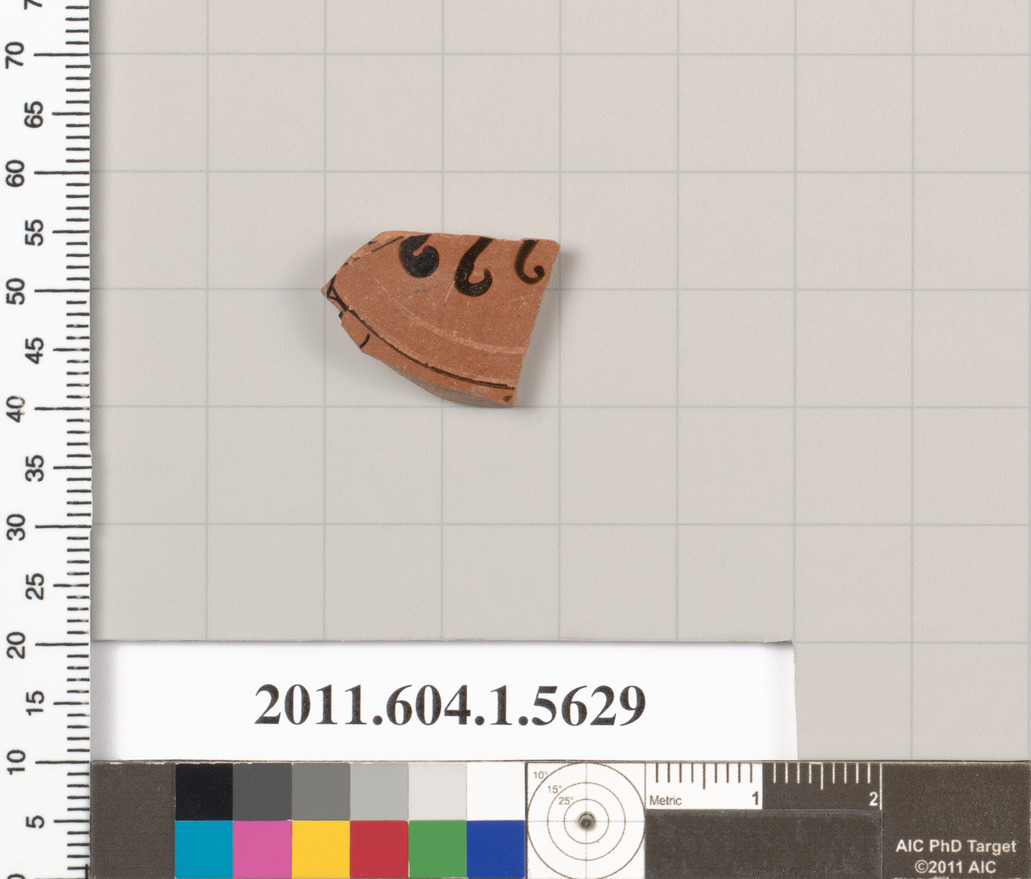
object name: kylix fragment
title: Terracotta fragment of a kylix (drinking cup)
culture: greek, attic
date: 520-500 BCE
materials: terracotta